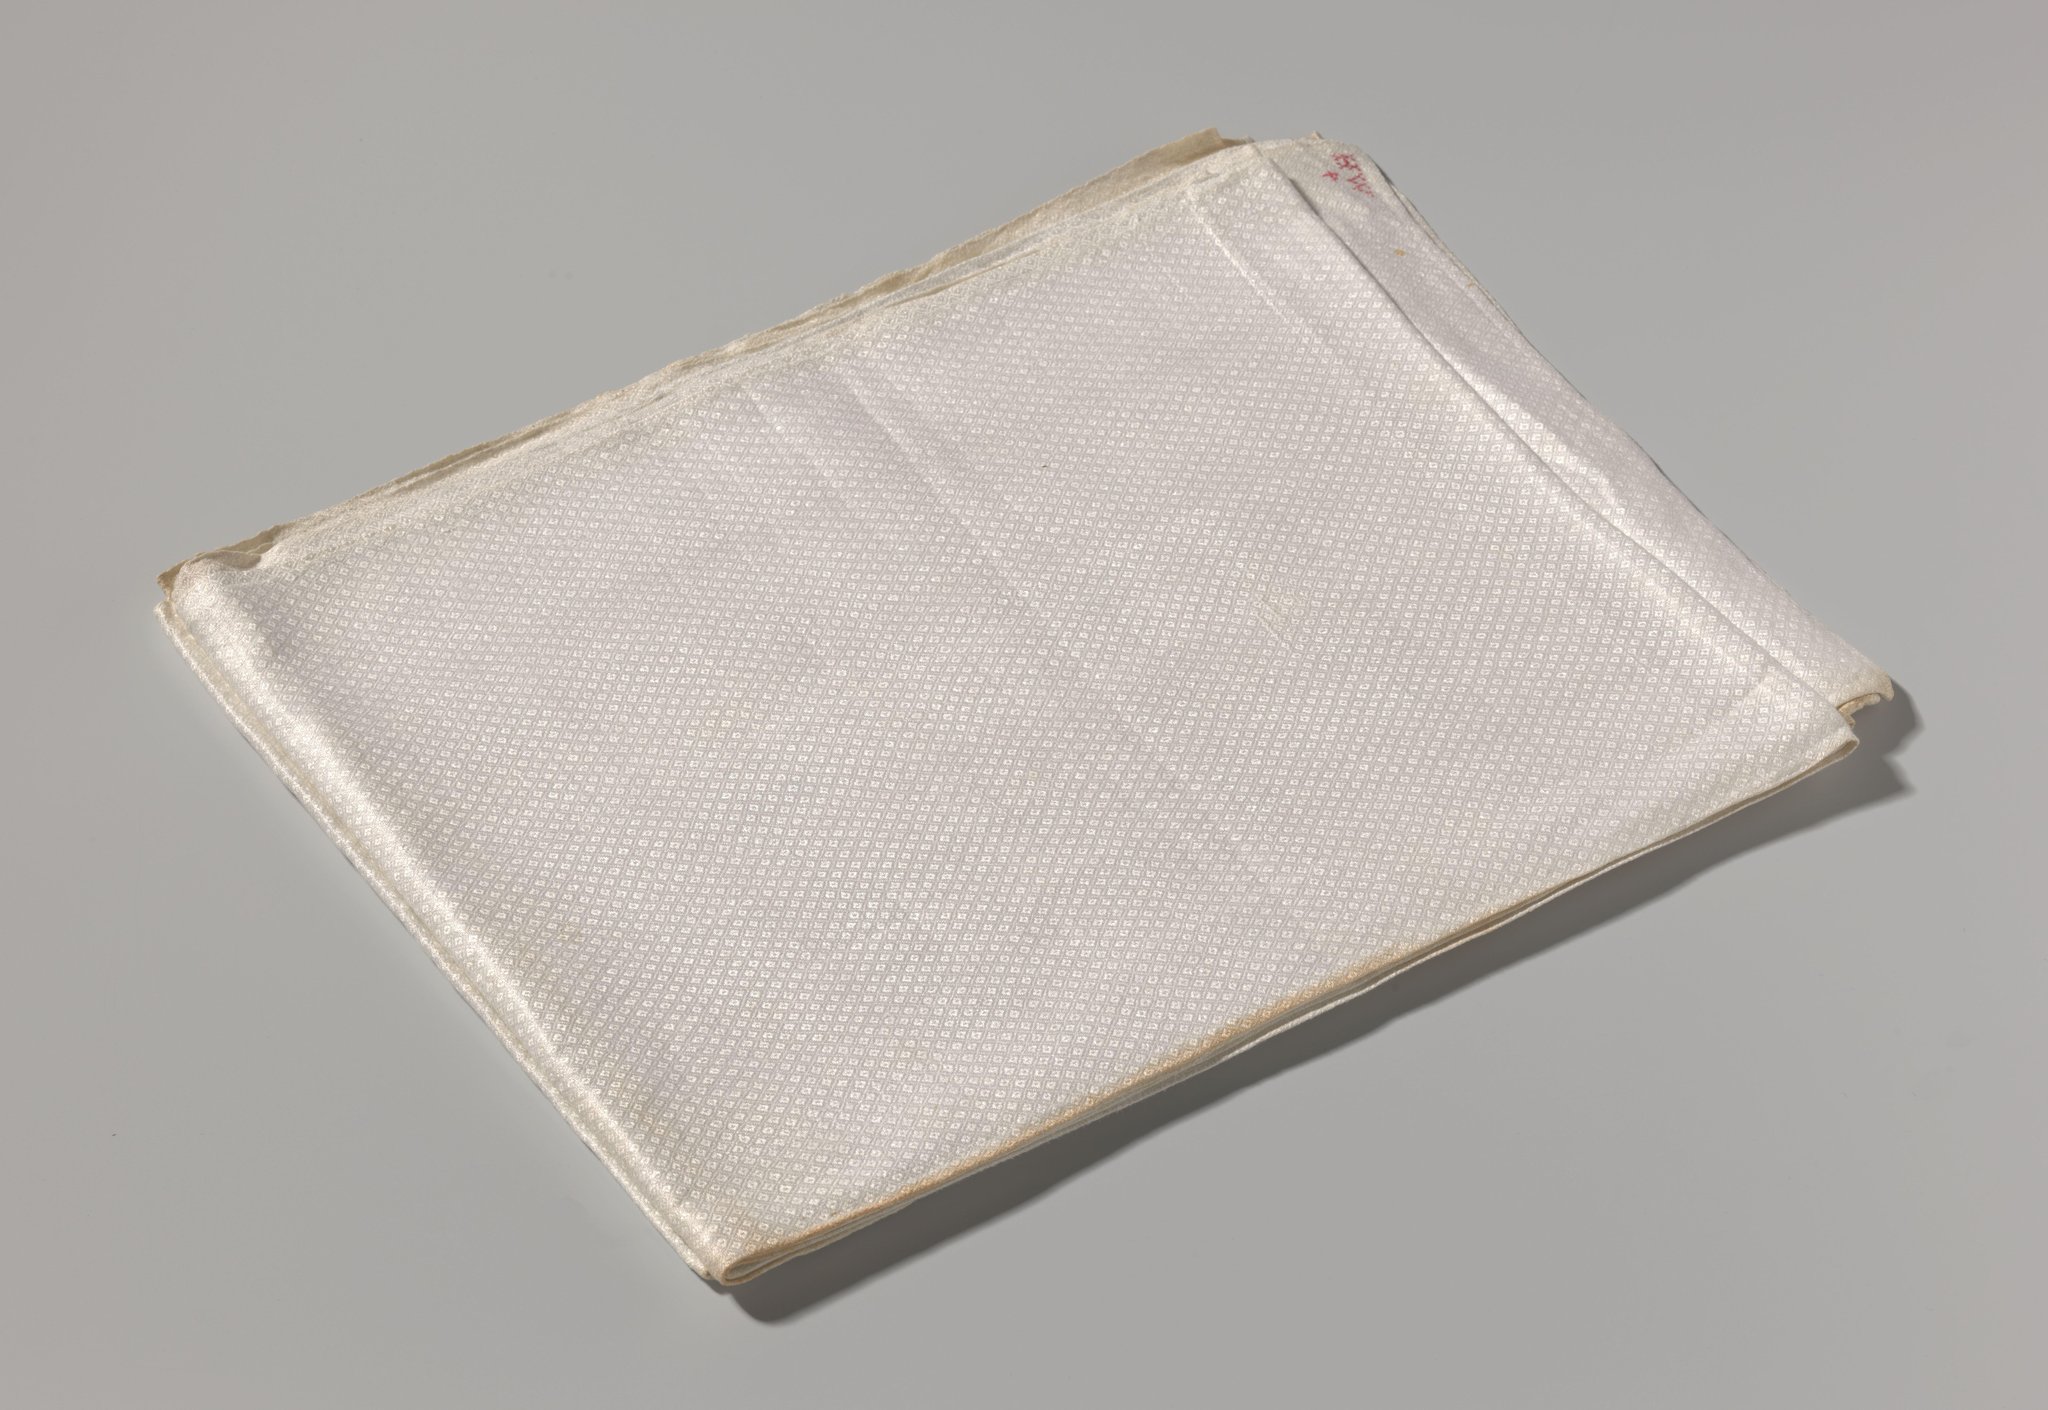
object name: woven material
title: Tafellaken met pellenpatroon "gansoog"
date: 1700-1800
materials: linen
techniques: peeled fabric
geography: netherlands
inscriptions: mark: ‘HW 4’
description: Tafellaken van linnen, pellen, patroon "gansoog". Gemerkt HW 4.